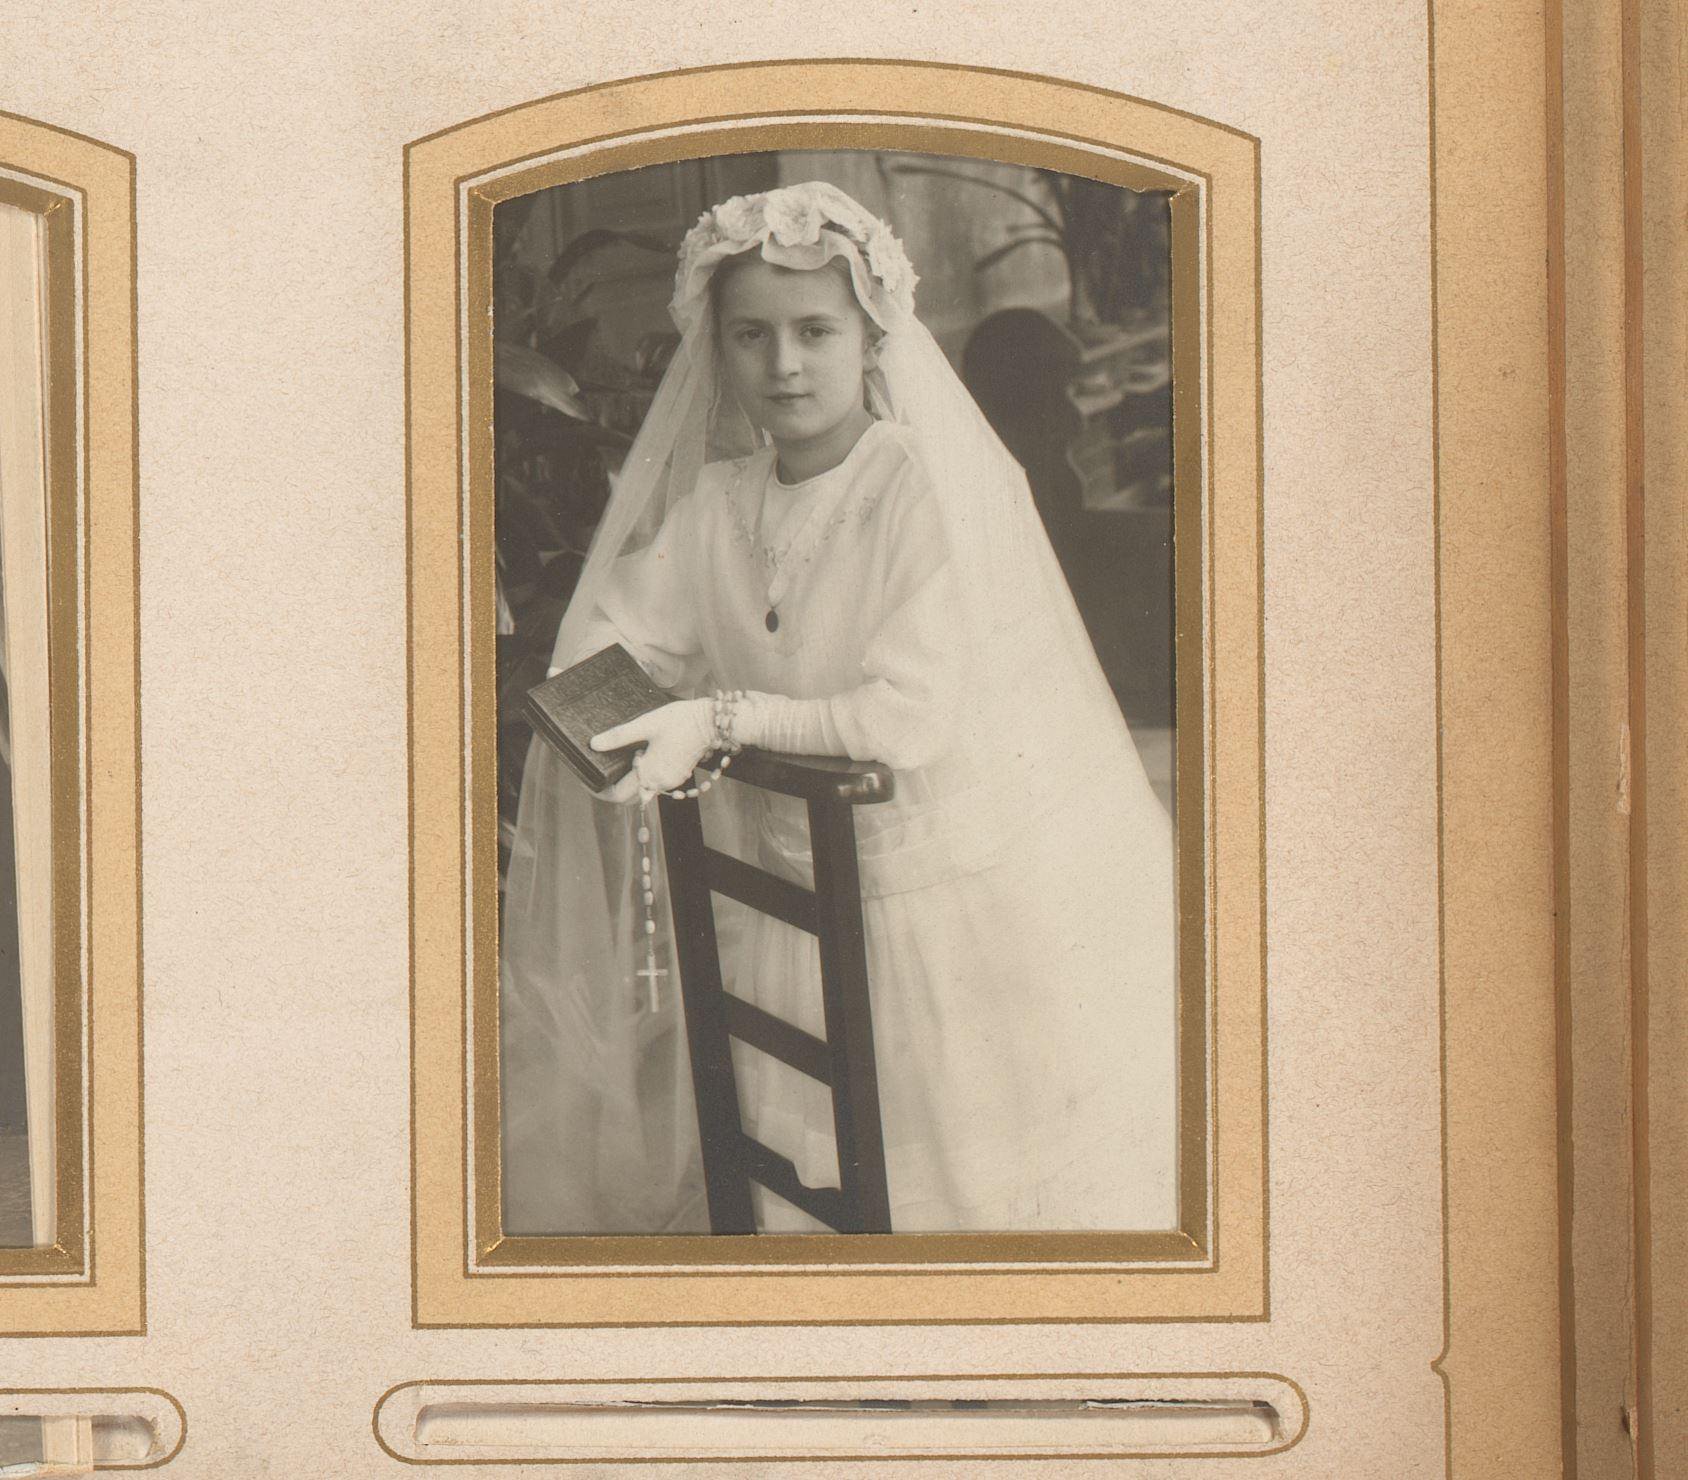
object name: photograph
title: Portret van een meisje in vermoedelijk een jurk voor de eerste communie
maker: Anonymous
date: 1860-1900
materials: cardboard, photographic support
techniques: albumen print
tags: clothes for official occasions, historical persons, girl (child between toddler and youth)